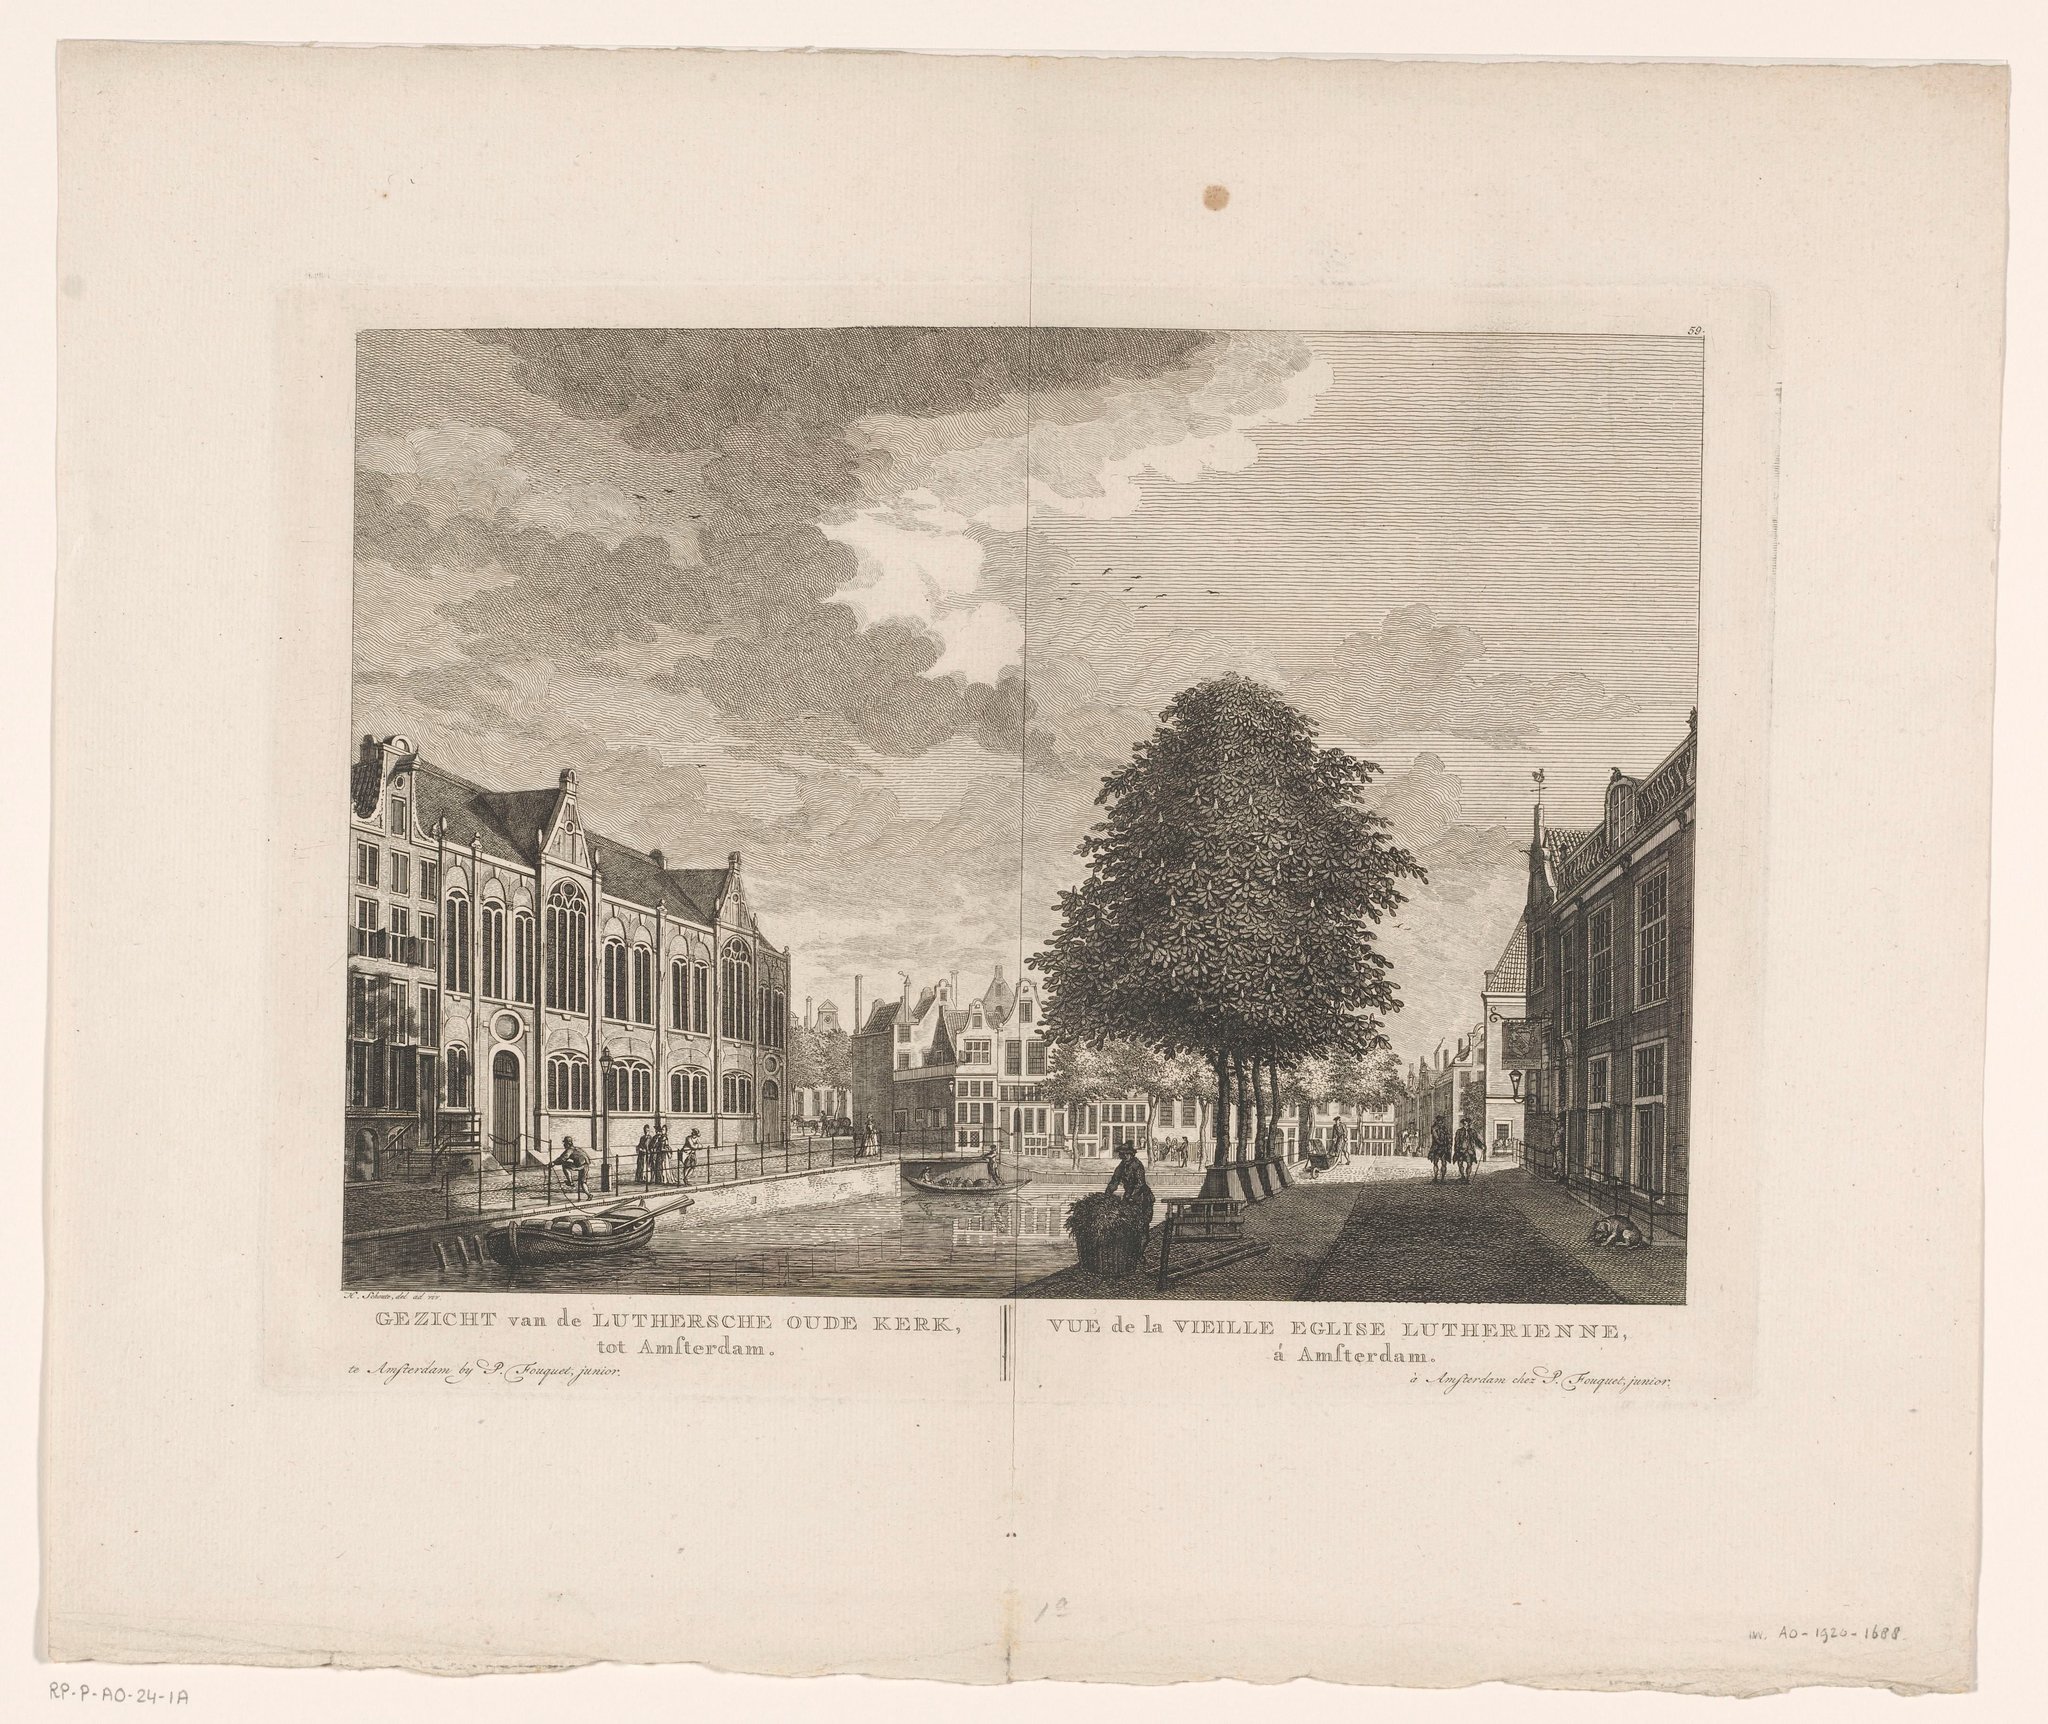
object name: print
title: Gezicht van de Luthersche Oude Kerk, tot Amsterdam / Vue de la Vieille Eglise Lutherienne, à Amsterdam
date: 1770-1783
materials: paper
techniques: engraving, etching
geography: amsterdam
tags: protestant churches and denominations (lutherans), church (exterior), canals, waters (in city) (+ city(-scape) with figures, staffage), street (+ city(-scape) with figures, staffage)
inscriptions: collector's mark: Lugt 2233, collector's mark: Lugt 2228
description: Deze prent is ook gebruikt in de zogenaamde Atlas van Fouquet.* Pierre Fouquet gaf vanaf 1760 stadsgezichten van Amsterdam - naar tekeningen van verschillende kunstenaars, gemaakt door verschillende prentmakers - uit. Deze prenten werden aanvankelijk los of in series verkocht. Zoals toen gebruikelijk kon de koper de prenten zelf laten inbinden. Hiertoe gaf Fouquet tussen 1778 en 1783 een titelblad, plattegrond en inhoudsopgave van de tot dusver 100 uitgegeven prenten uit (1). Gezien de inhoud afhankelijk was van wat de koper had verzameld verschilt de inhoud van de verschillende bewaarde Fouquetatlassen onder deze titel sterk. Ook zijn er exemplaren bekend waar tevens andere prenten aan zijn toegevoegd. Omdat er behoefte bleek aan uitleg bij de platen werd in 1783 een nieuwe versie van de atlas uitgegeven, aangevuld met tekst en twee prenten. De aangegeven volgorde veranderde maar de platen van de al eerder uitgegeven prenten bleven ongewijzigd. Deze uitgave werd in opdracht van Fouquet gedrukt bij Daniël Jean Changuion en Petrus den Hengst (2). Een tiental platen werd bijgewerkt en verscheen, met nieuw impressum, in het vervolg van Wagenaars geschiedenis van Amsterdam, uitgeven door Petrus Conradi en Folkert van der Plaats (3). Een aantal jaar na het overlijden van Fouquet kwam Evert Maaskamp met een nieuwe uitgave van de atlas, met verbeterde tekst en toevoeging van twee prenten. Op alle platen verwijderde hij het oude en liet hij zijn eigen impressum zetten (4). De huidige staat van de prent komt voor in exemplaren van de onder (1) en (2) genoemde werken. * Onder de Atlas van Fouquet of Fouquetatlas verstaan we de hieronder vermelde publicaties (1), (2) en (4). (1). Afbeeldingen van de wyd-vermaarde koopstad Amsterdam benevens des zelvs voornaamste gebouwen en gezigten alle naar het leeven getekend / Receuil des edifices les plus considerables et des plus belles vues, de la fameuse ville d'Amsterdam, dessinées d'après nature. Amsterdam: Pierre Fouquet, 1778-1783. (2). Nieuwe atlas, van de voornaamste gebouwen en gezigten der stad Amsterdam, met derzelver beknopte beschryvingen. 2 delen. Amsterdam: Daniël Jean Changuion en Petrus den Hengst [in opdracht van Pierre Fouquet], 1783. (3). Stijl, Simon. Amsterdam, in zyne geschiedenissen, voorregten, koophandel, gebouwen, kerkenstaat, schoolen, schutterye, gilden en regeeringe, beschreeven. Om te dienen ten vervolge op het werk van Jan Wagenaar (…). 10 delen. Amsterdam en Harlingen: Petrus Conradi en Folkert van der Plaats, 1788-1801. (4). Nieuwe atlas, van de voornaamste gebouwen en gezigten der stad Amsterdam. Met derzelver beknopte beschryvingen. Amsterdam: Evert Maaskamp, 1805. * Het aantal vermelde staten is gebaseerd op het aantal gevonden staten. Mogelijk zijn er meer staten van deze prent.